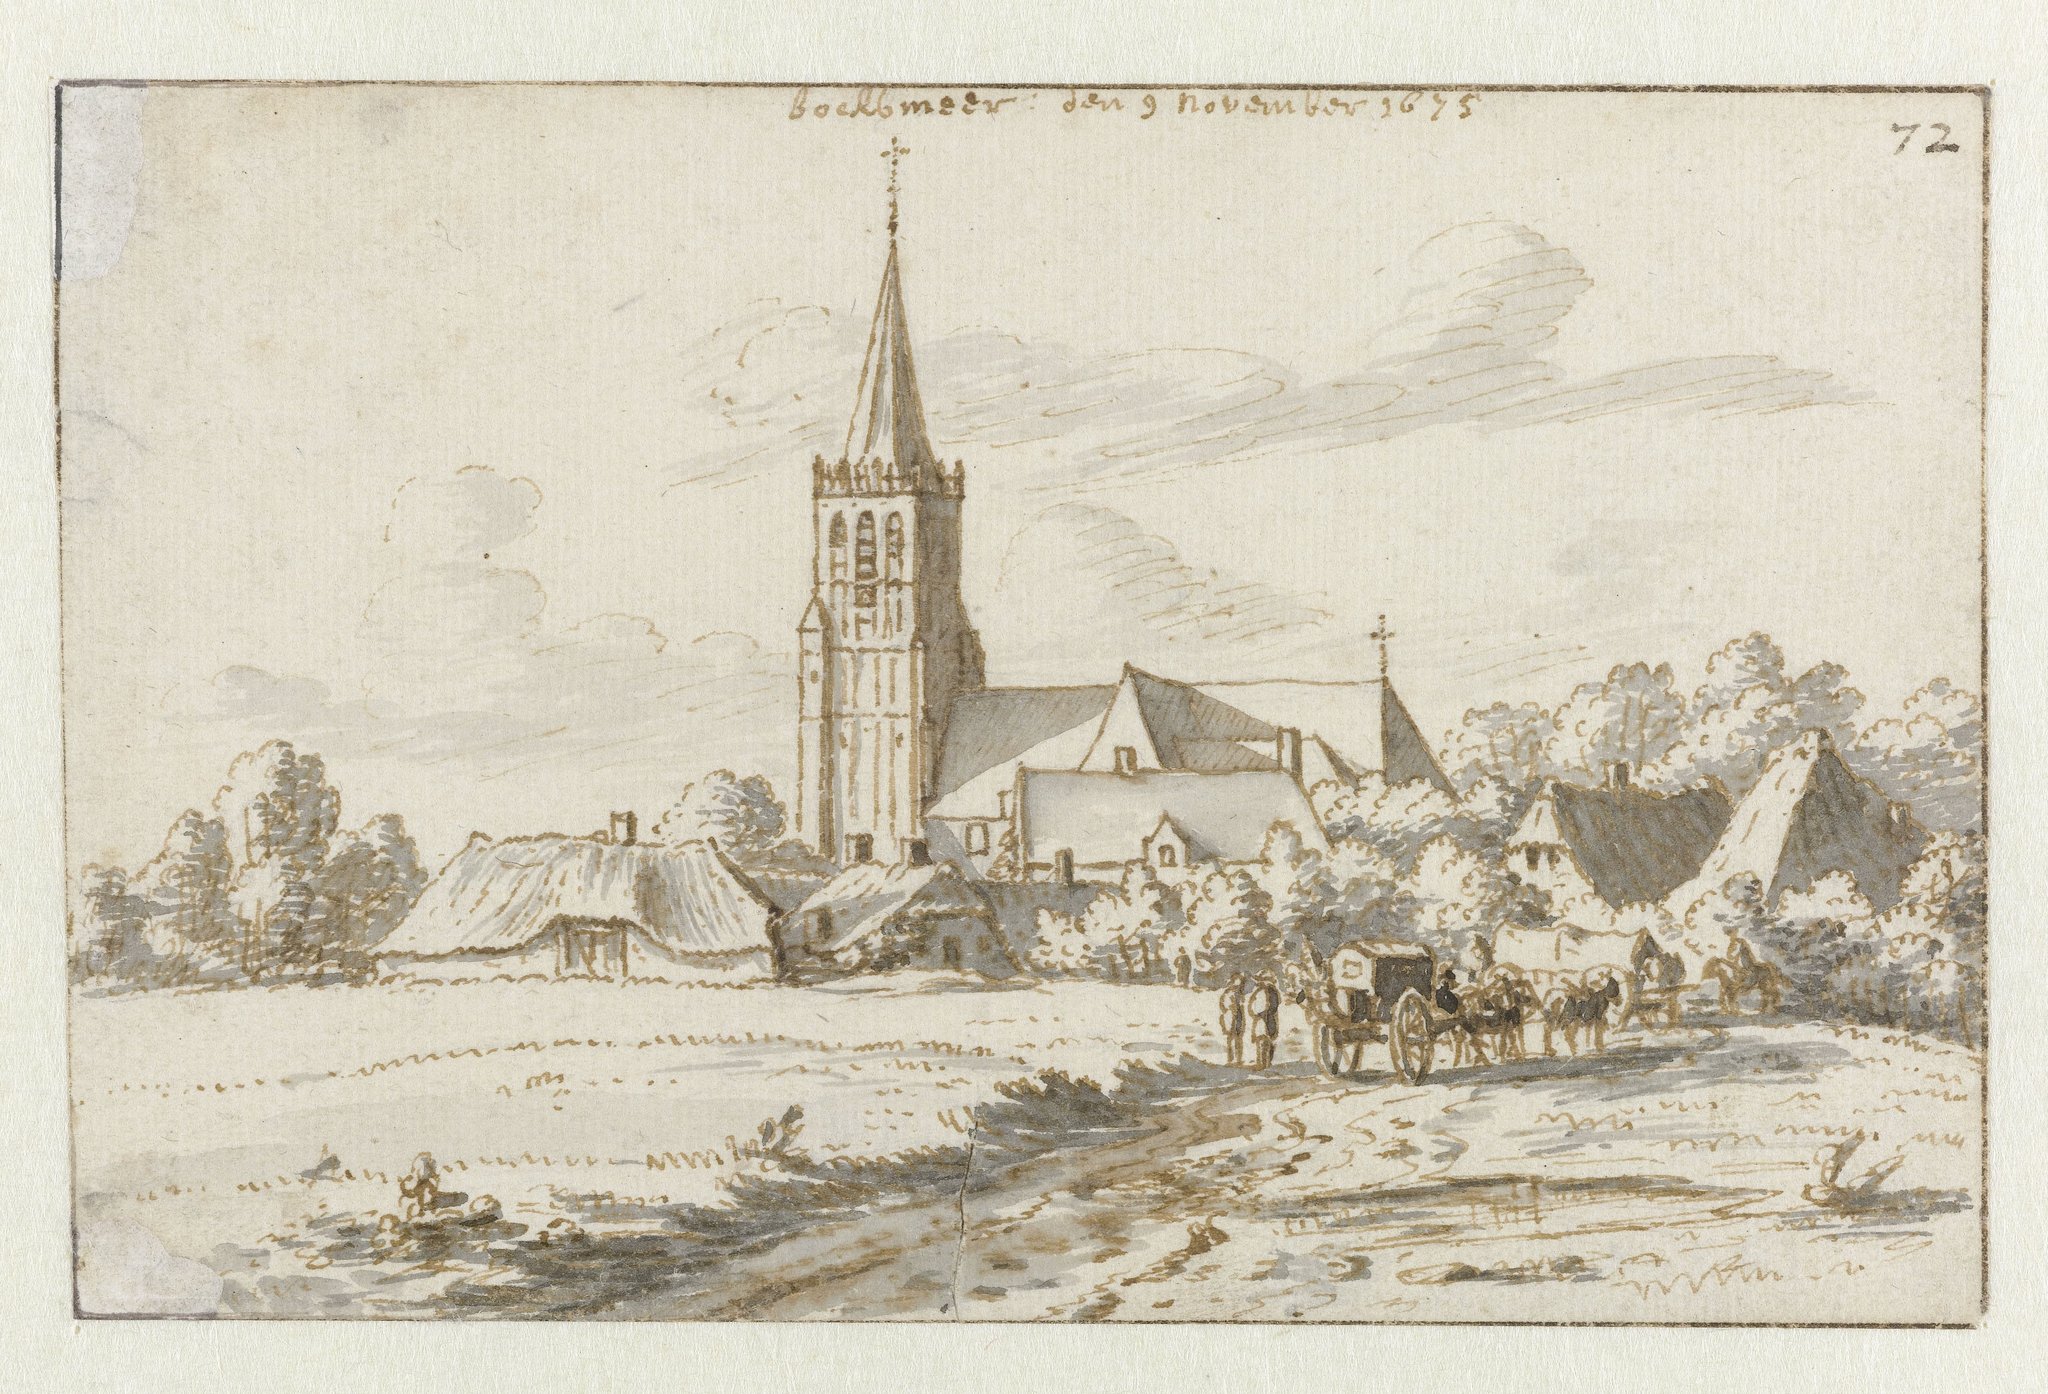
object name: drawing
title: View of Boxmeer, Noord-Brabant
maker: barend klotz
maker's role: draughtsman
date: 1675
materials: ink, paper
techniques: brush, pen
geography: boxmeer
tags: prospect of village, silhouette of village, church (exterior), boxmeer